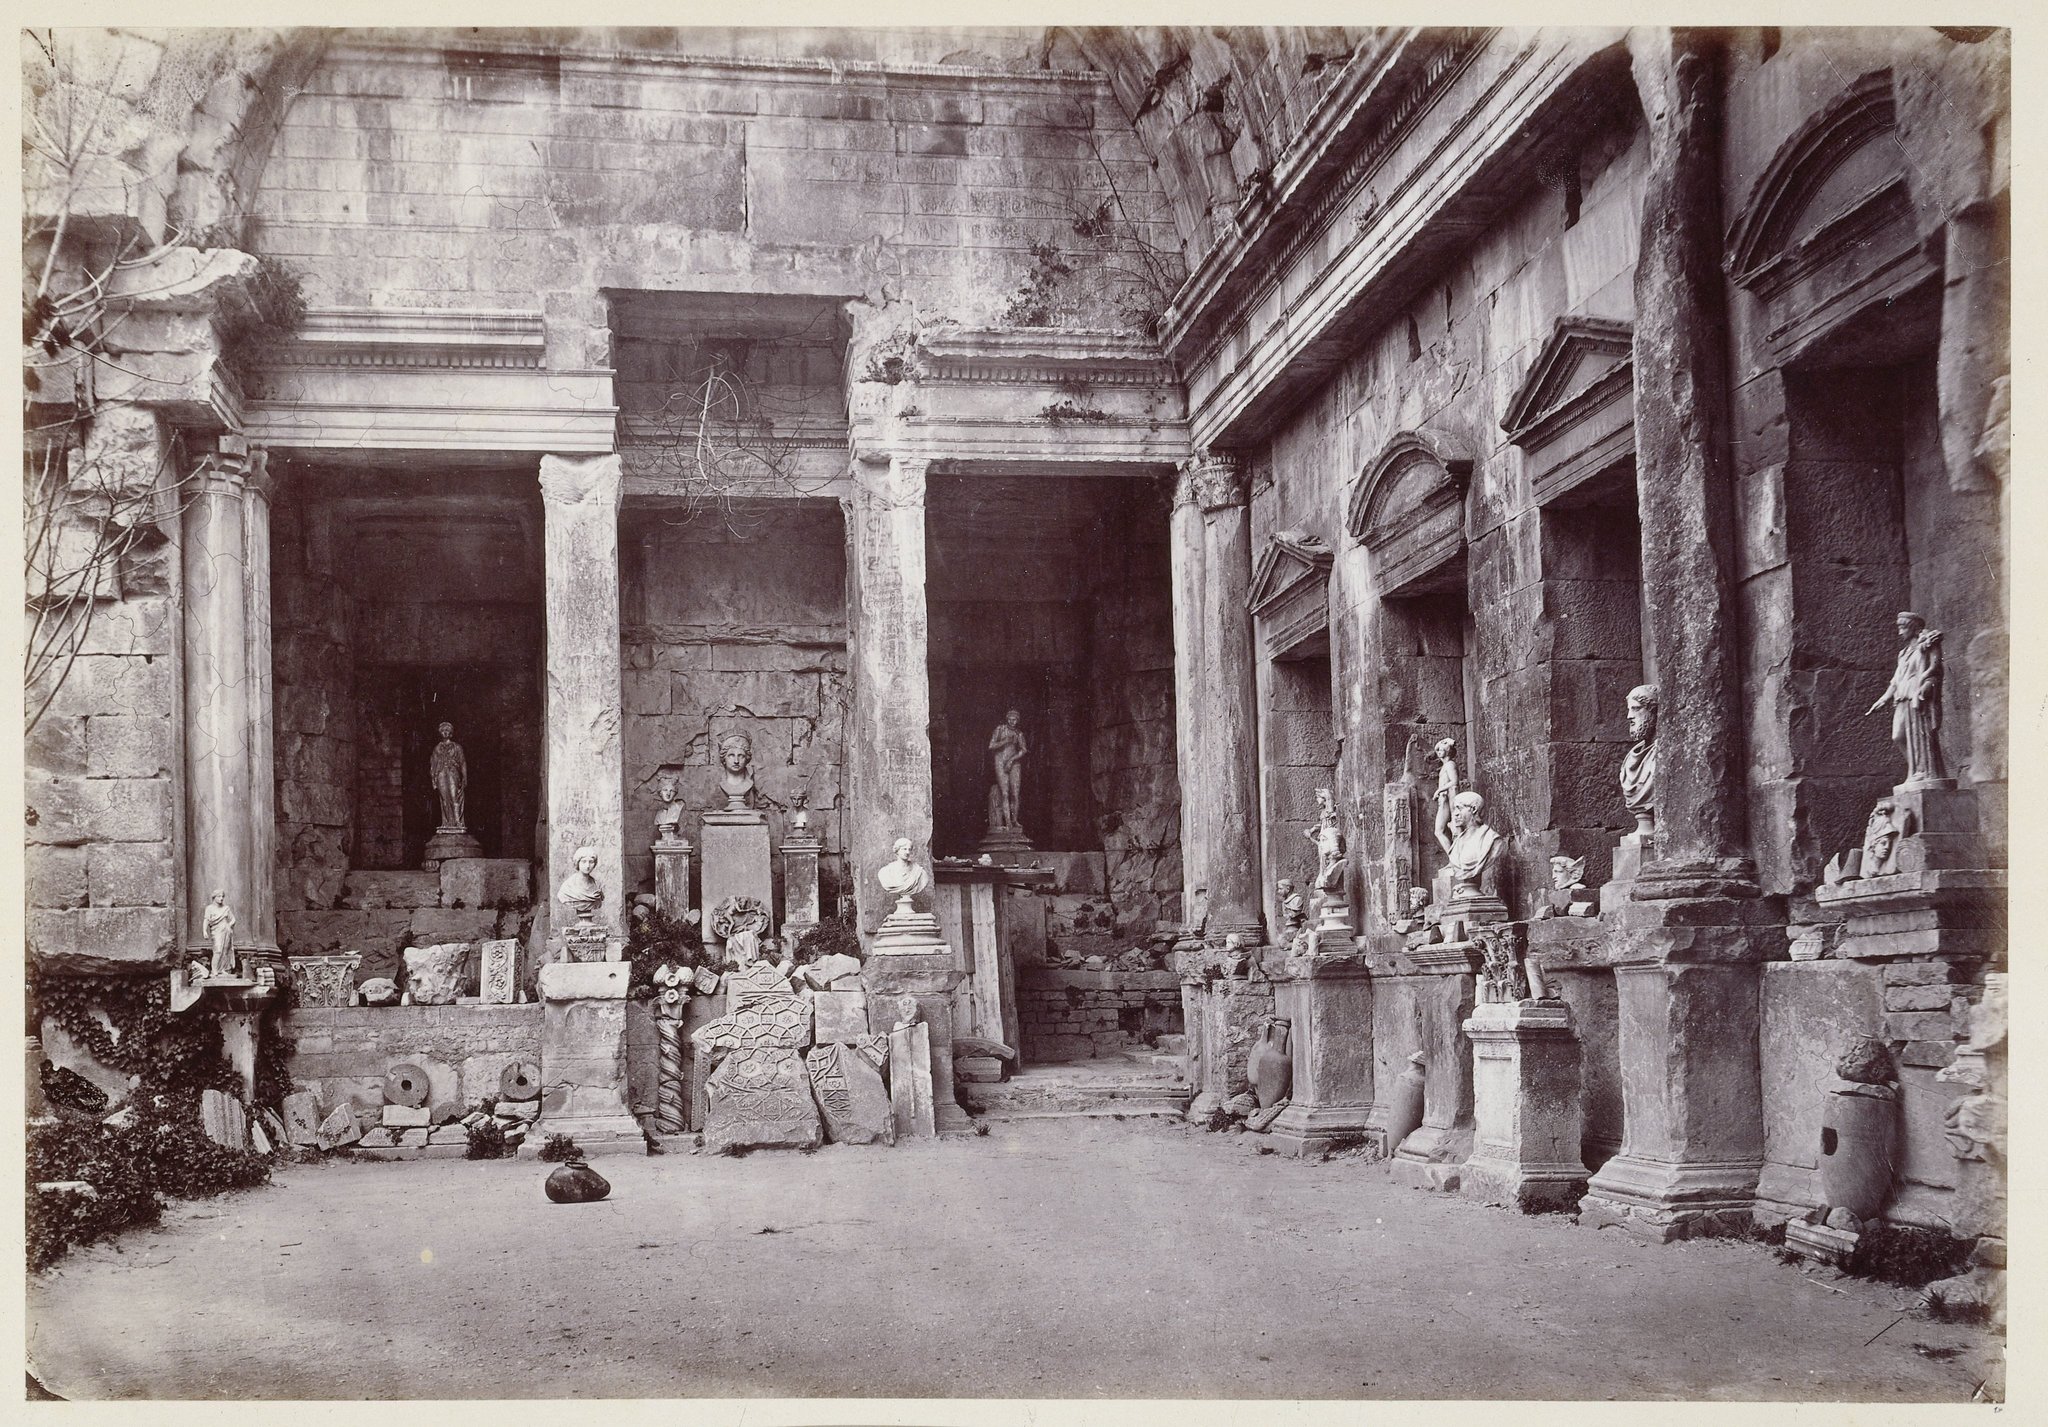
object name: photograph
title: Binnenplaats van de tempel van Diana te Nîmes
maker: édouard denis baldus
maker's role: fotograaf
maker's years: 1813-1889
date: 1859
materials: cardboard, photographic support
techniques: albumen print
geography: france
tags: temple, shrine ~ roman religion